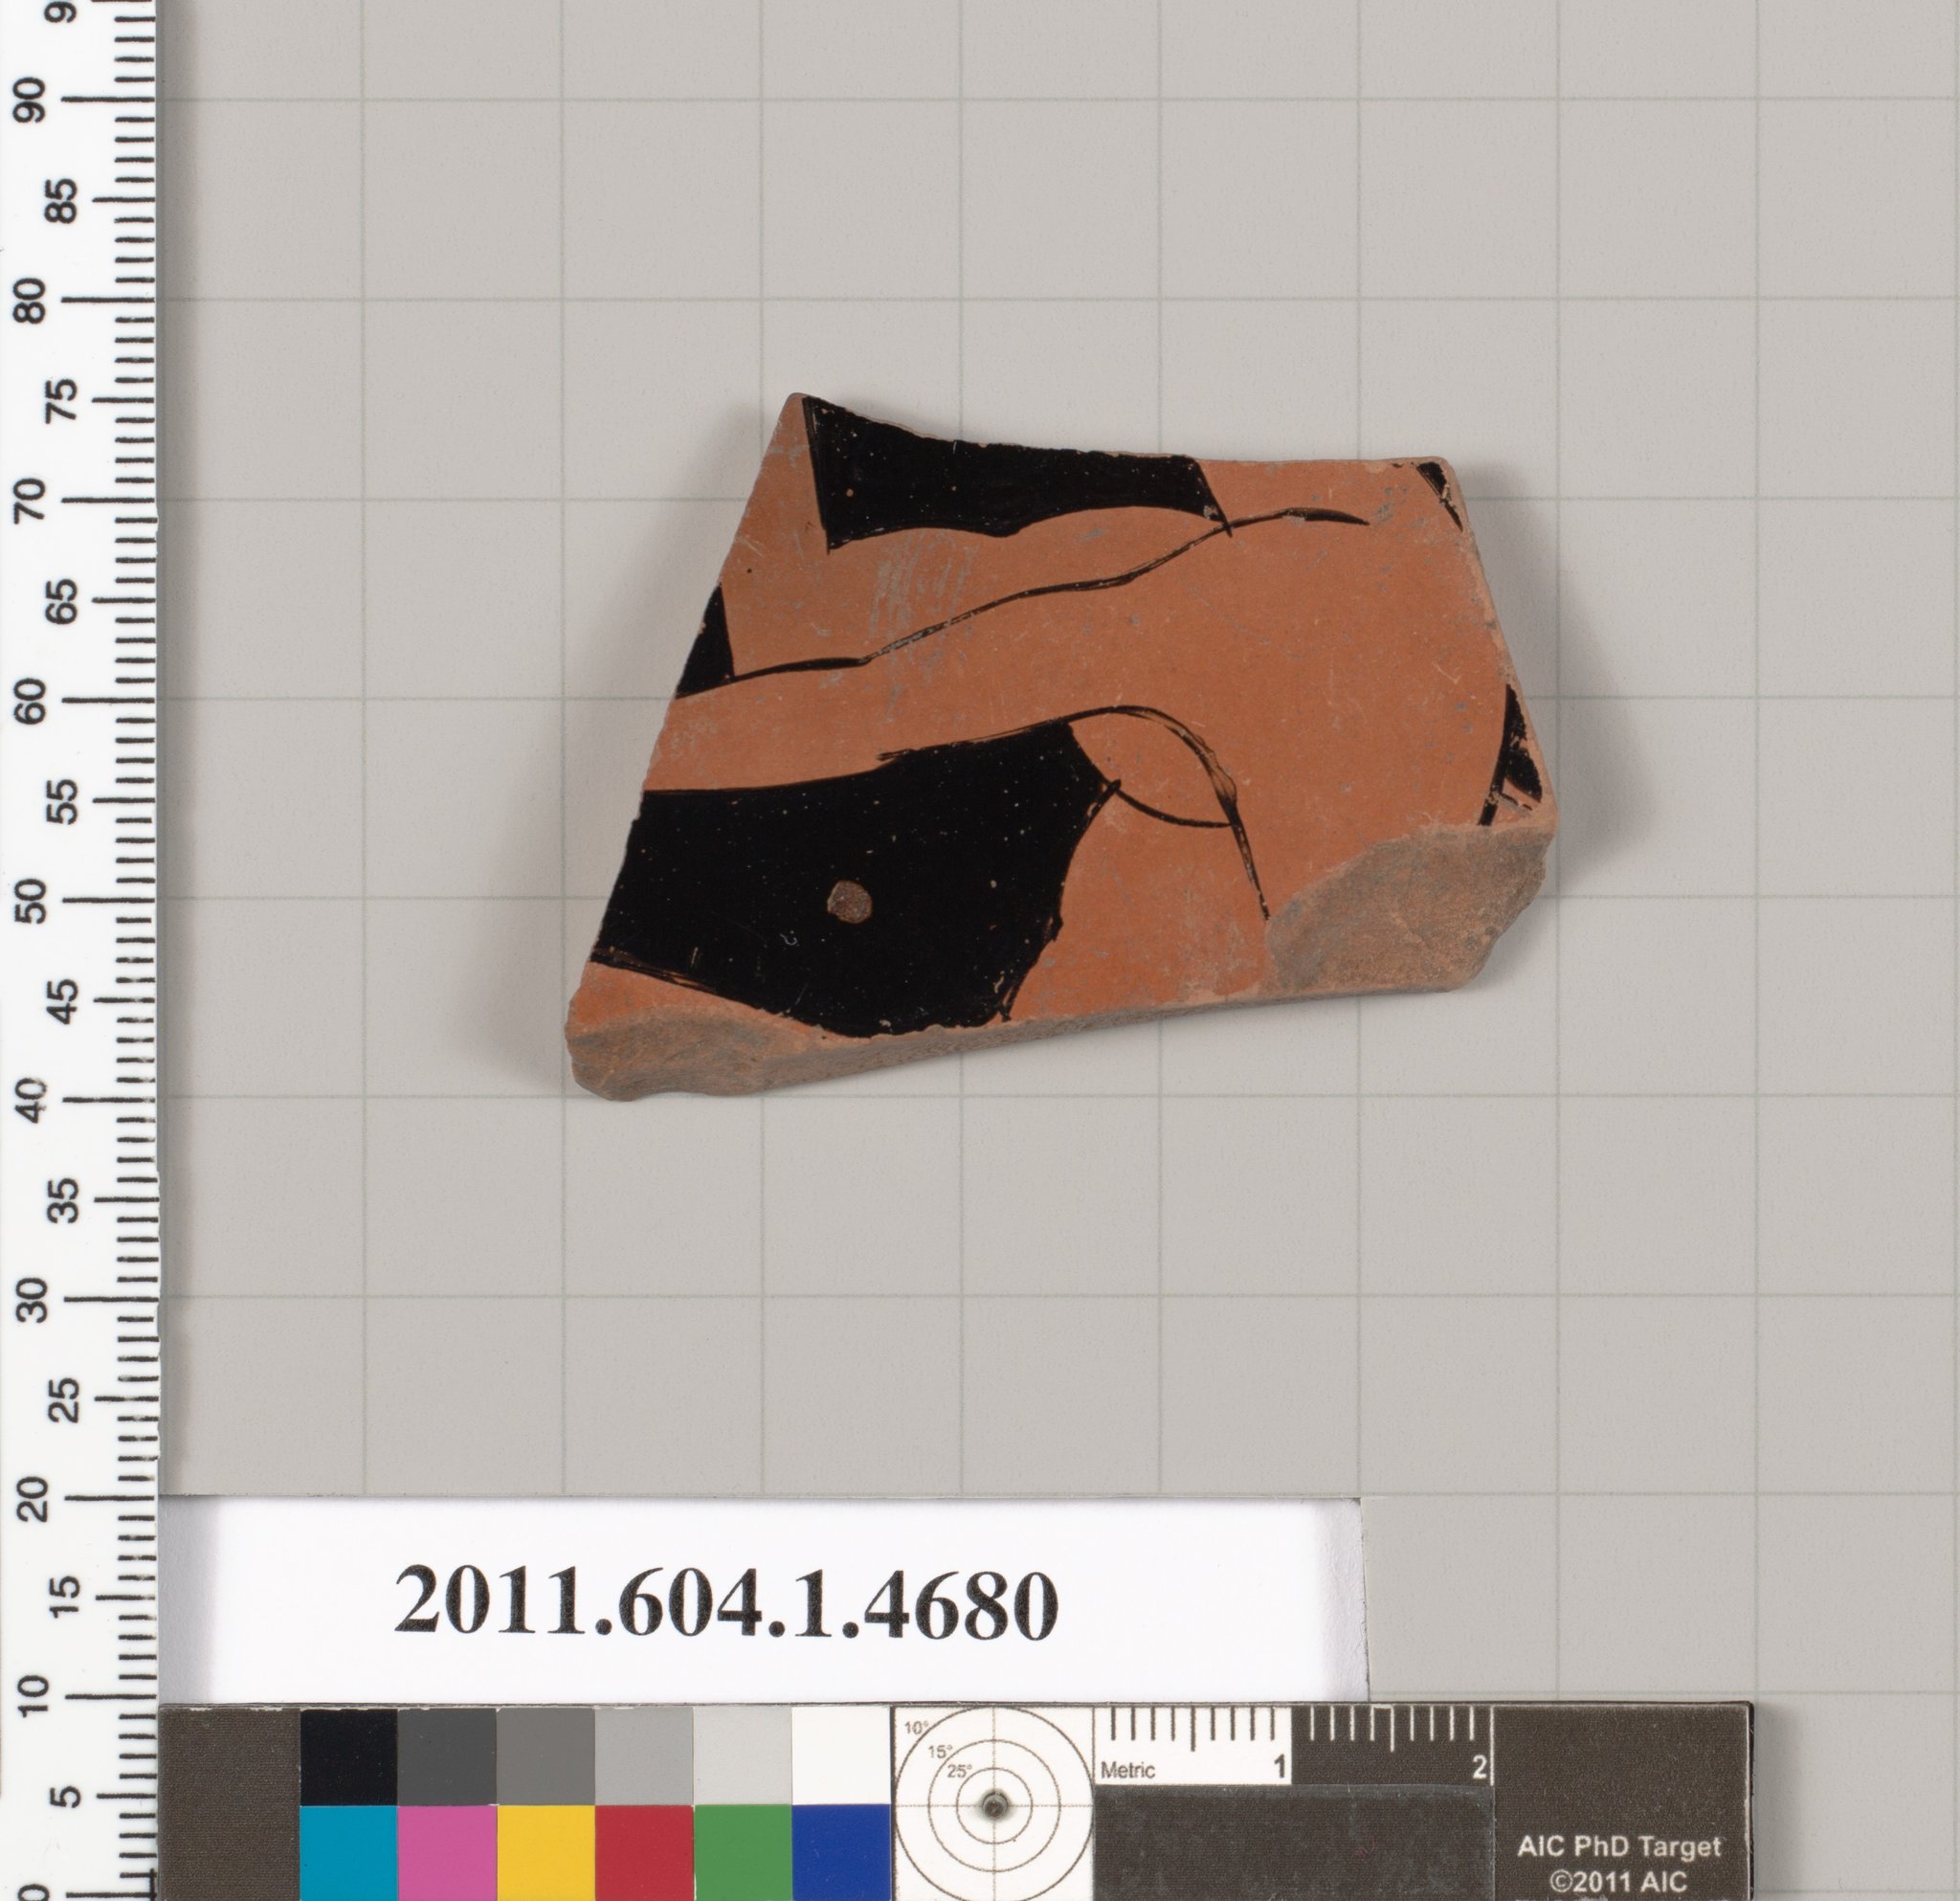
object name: kylix fragment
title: Terracotta fragment of a kylix (drinking cup)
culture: greek, attic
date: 510-490 BCE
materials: terracotta